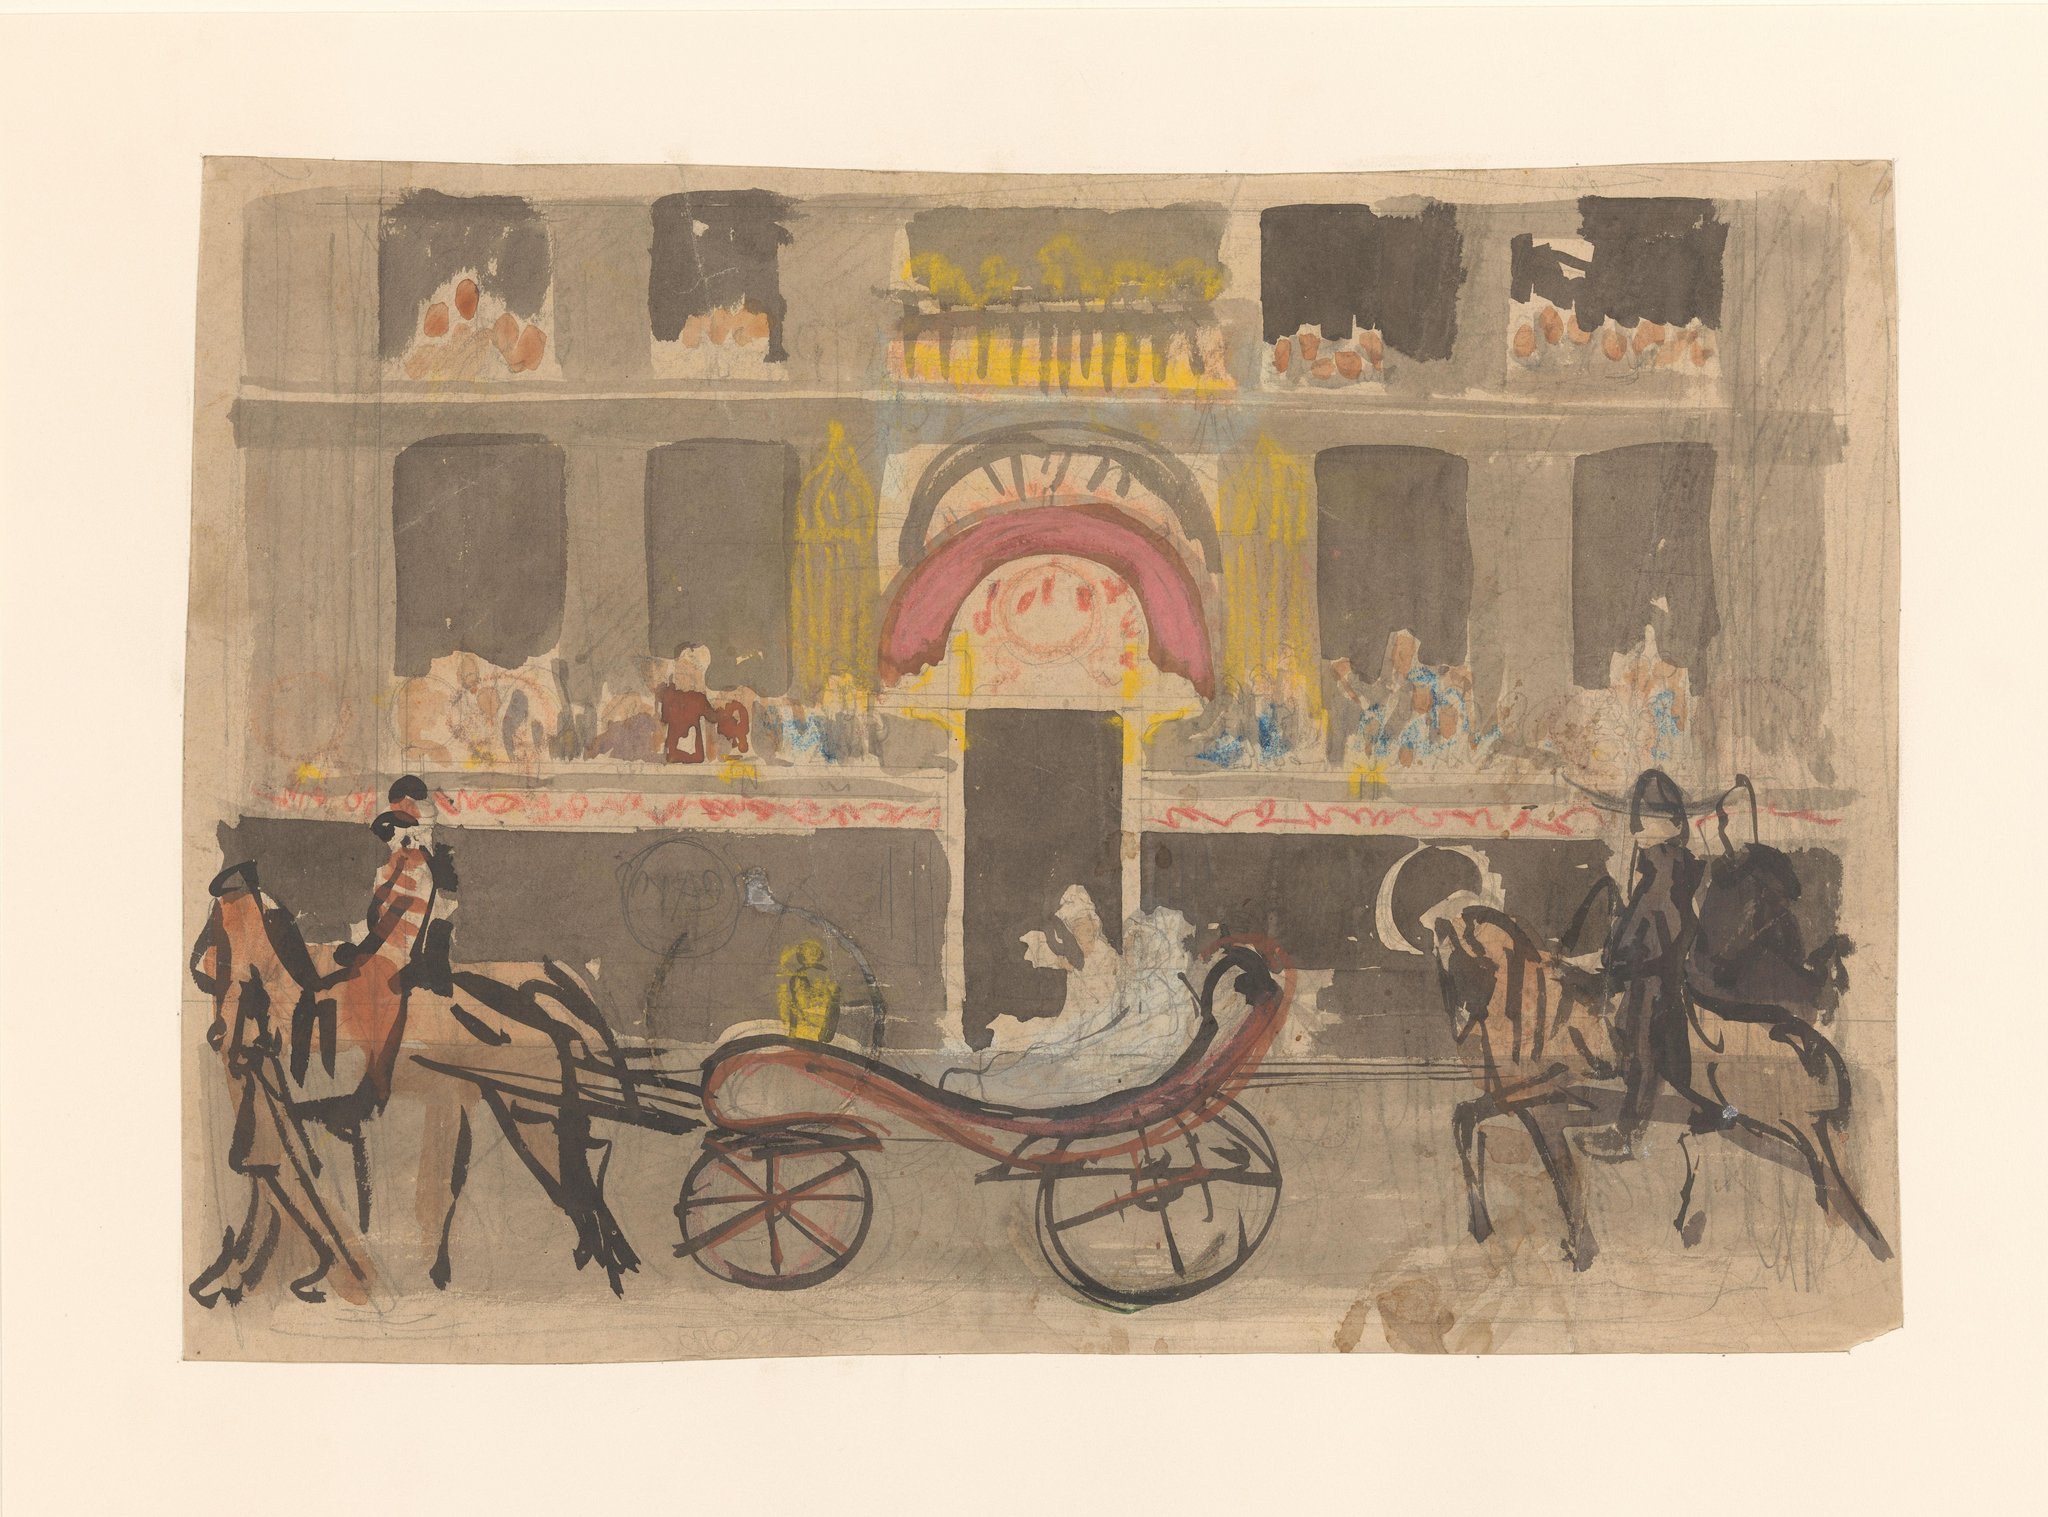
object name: drawing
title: Ontwerp voor versiering voor Herengracht 527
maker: carel adolph lion cachet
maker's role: draughtsman, print maker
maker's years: 1864-1945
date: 1898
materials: paper, pastel, pencil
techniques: brush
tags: four-wheeled, animal-drawn vehicle, e.g.: cab, carriage, coach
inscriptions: date: ‘1898’